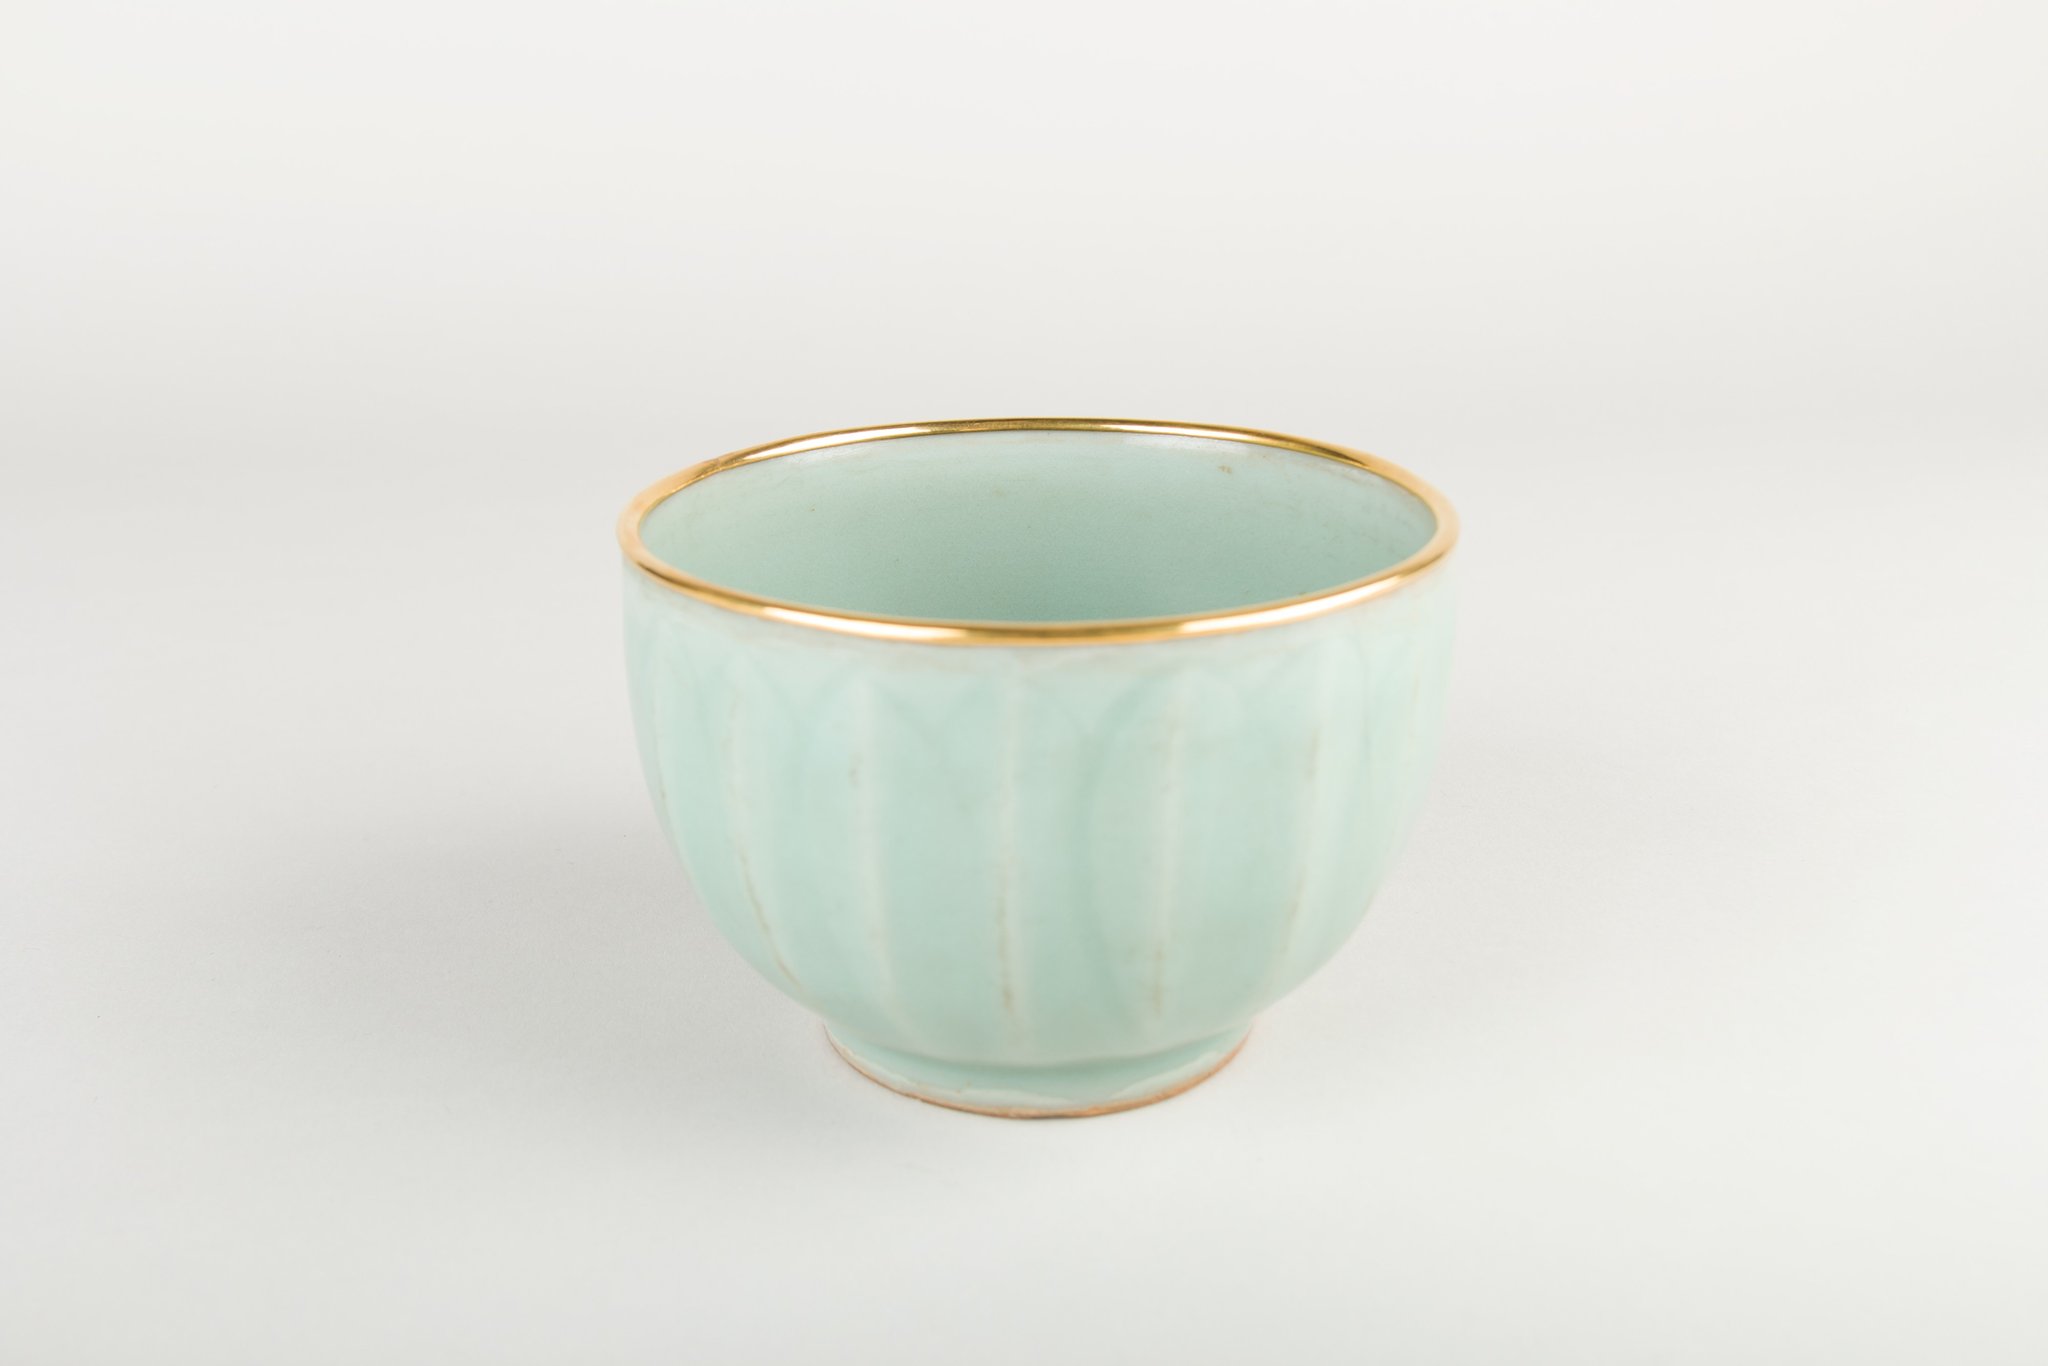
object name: bowl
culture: chinese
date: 960-1279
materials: ceramic glaze, glaze